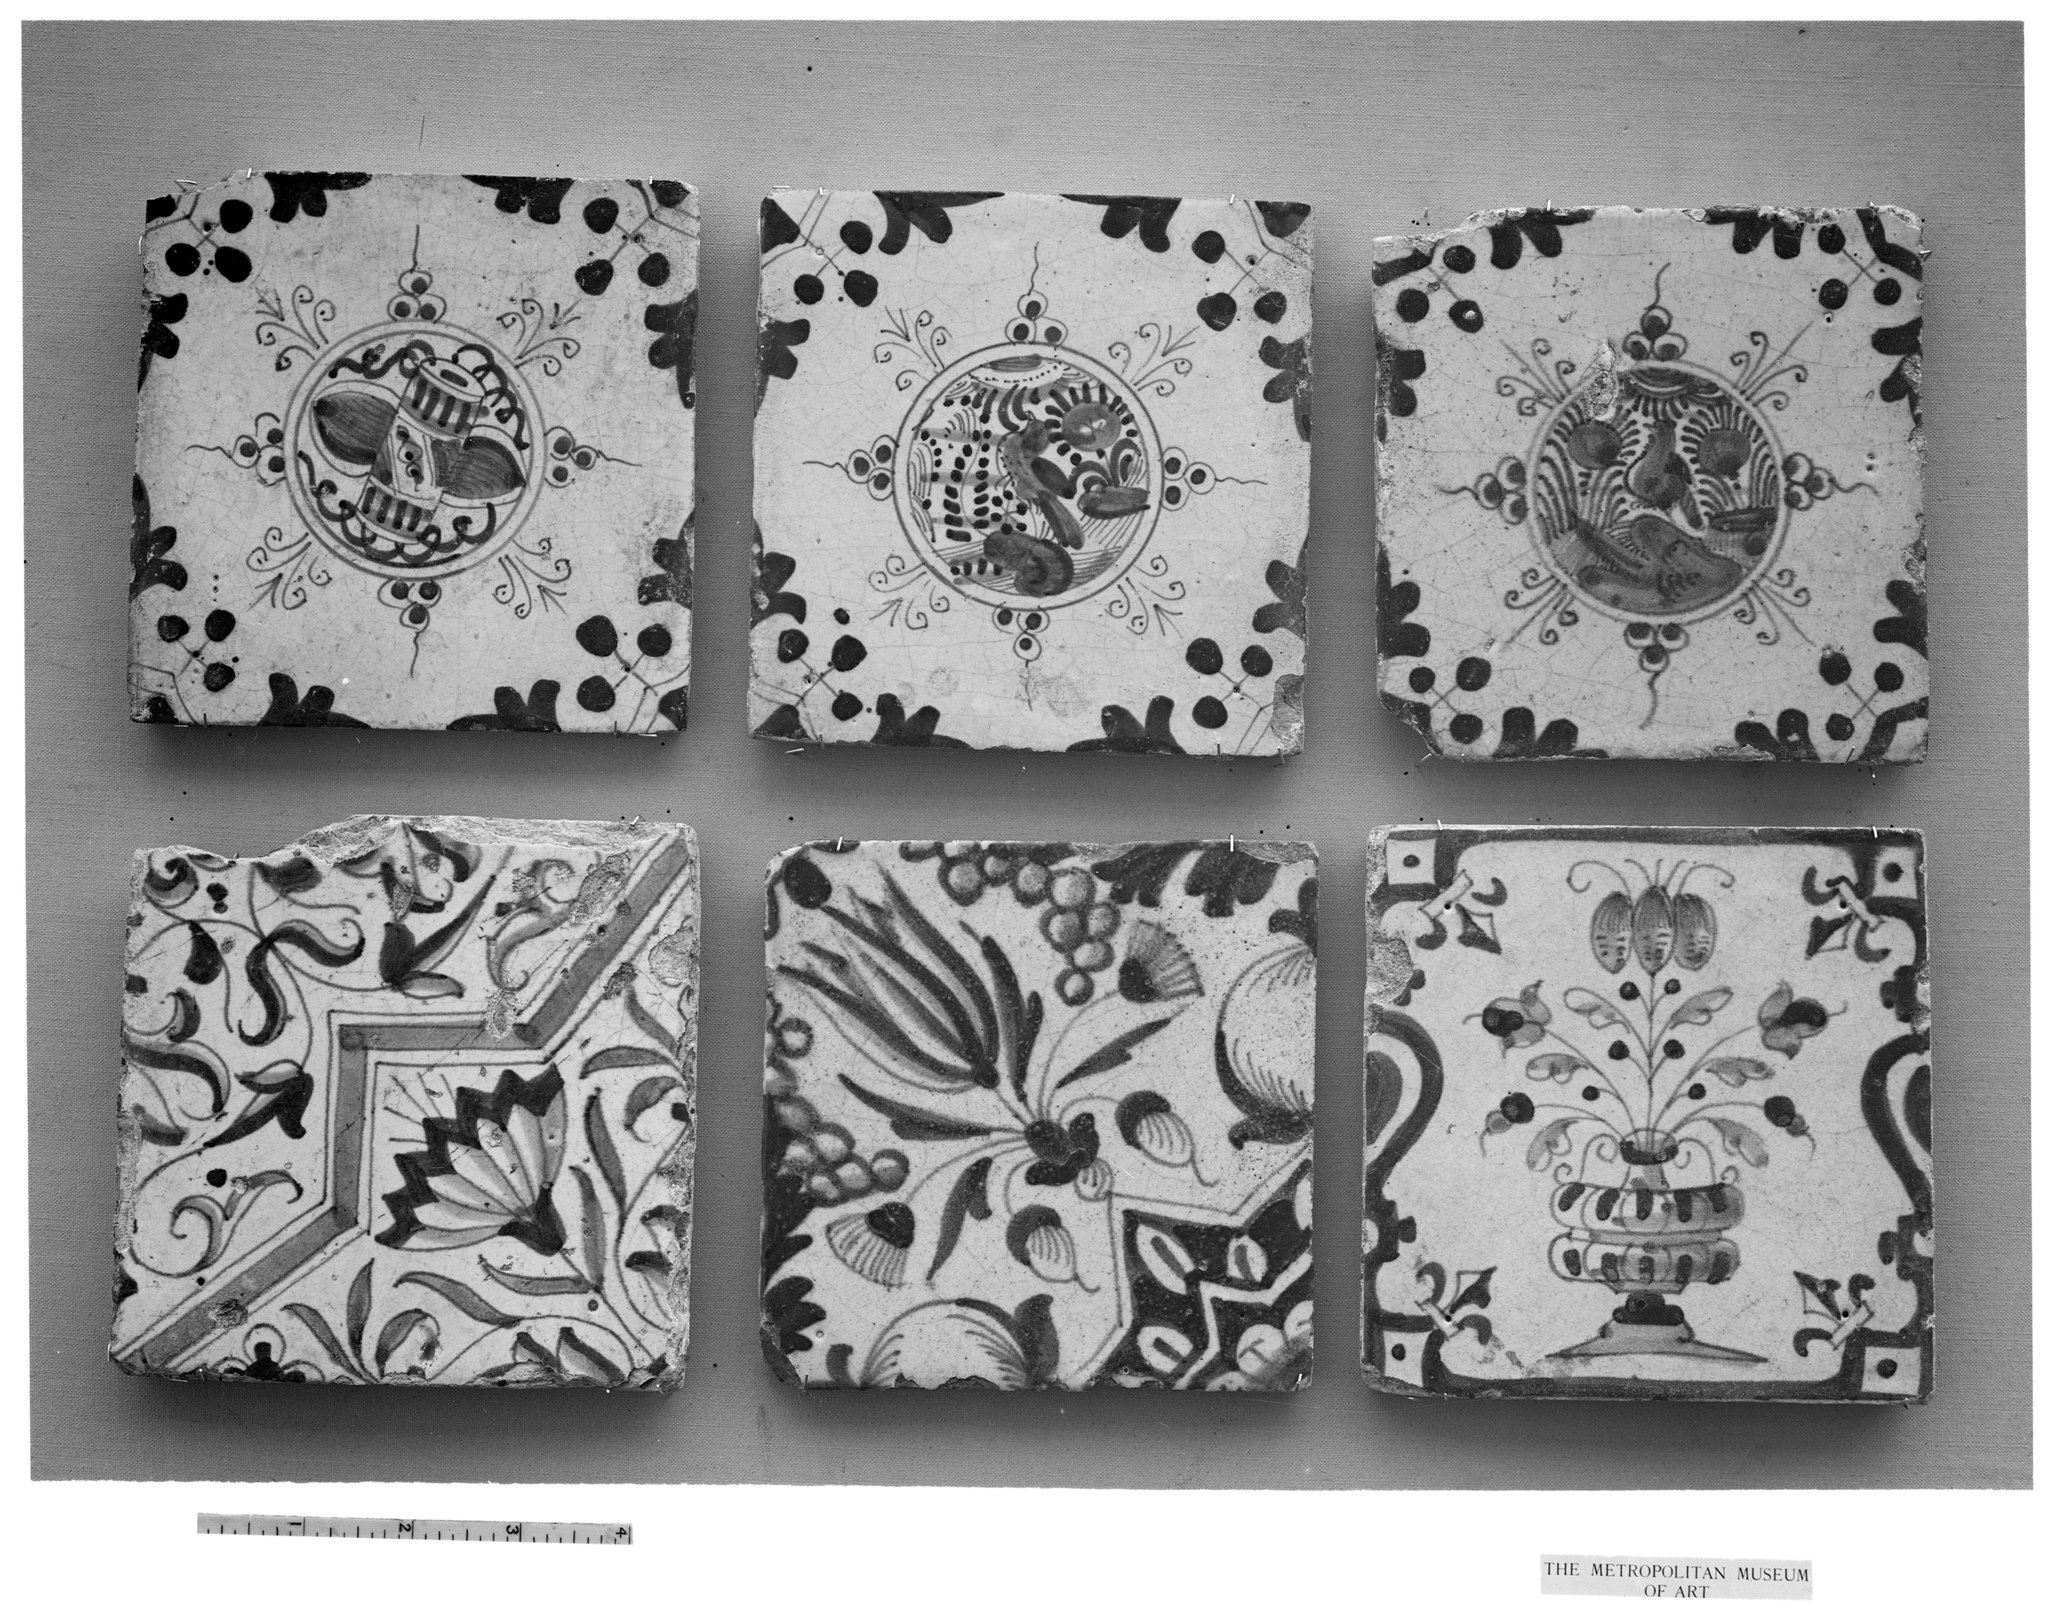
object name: tile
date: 1630-1640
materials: earthenware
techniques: glazing